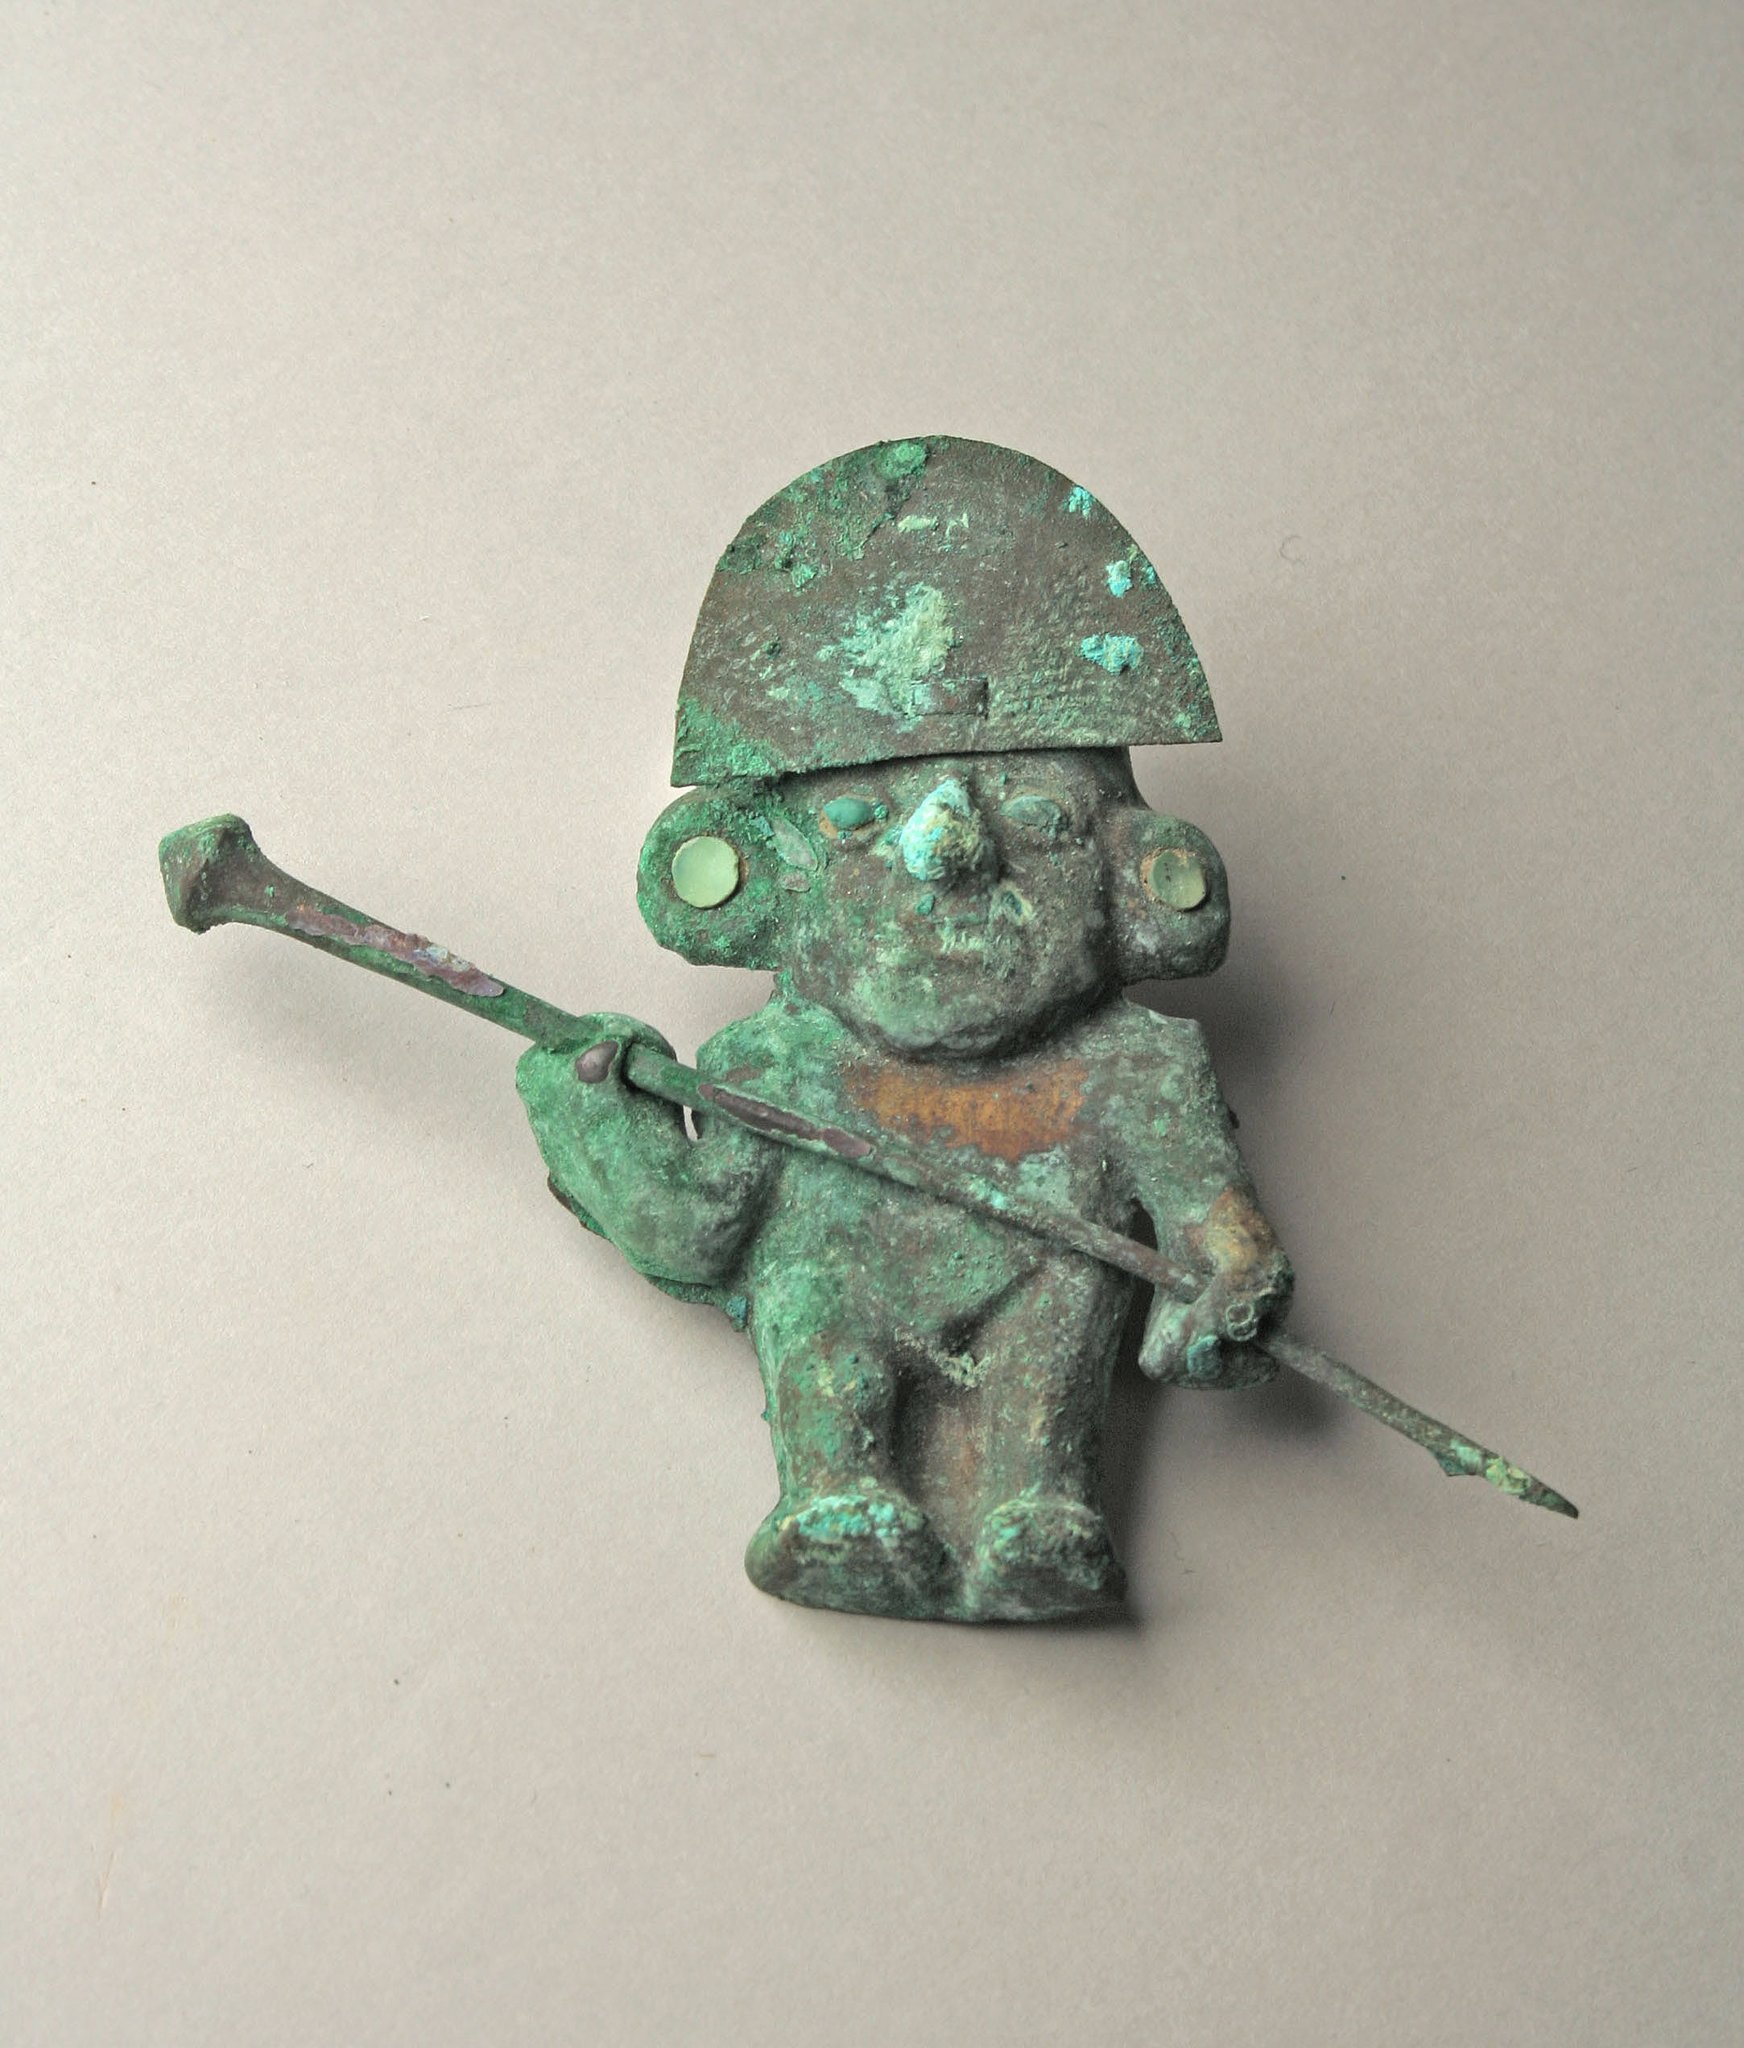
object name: ornament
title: Warrior Figure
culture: moche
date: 501-700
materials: gilt copper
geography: peru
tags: weapons,warriors